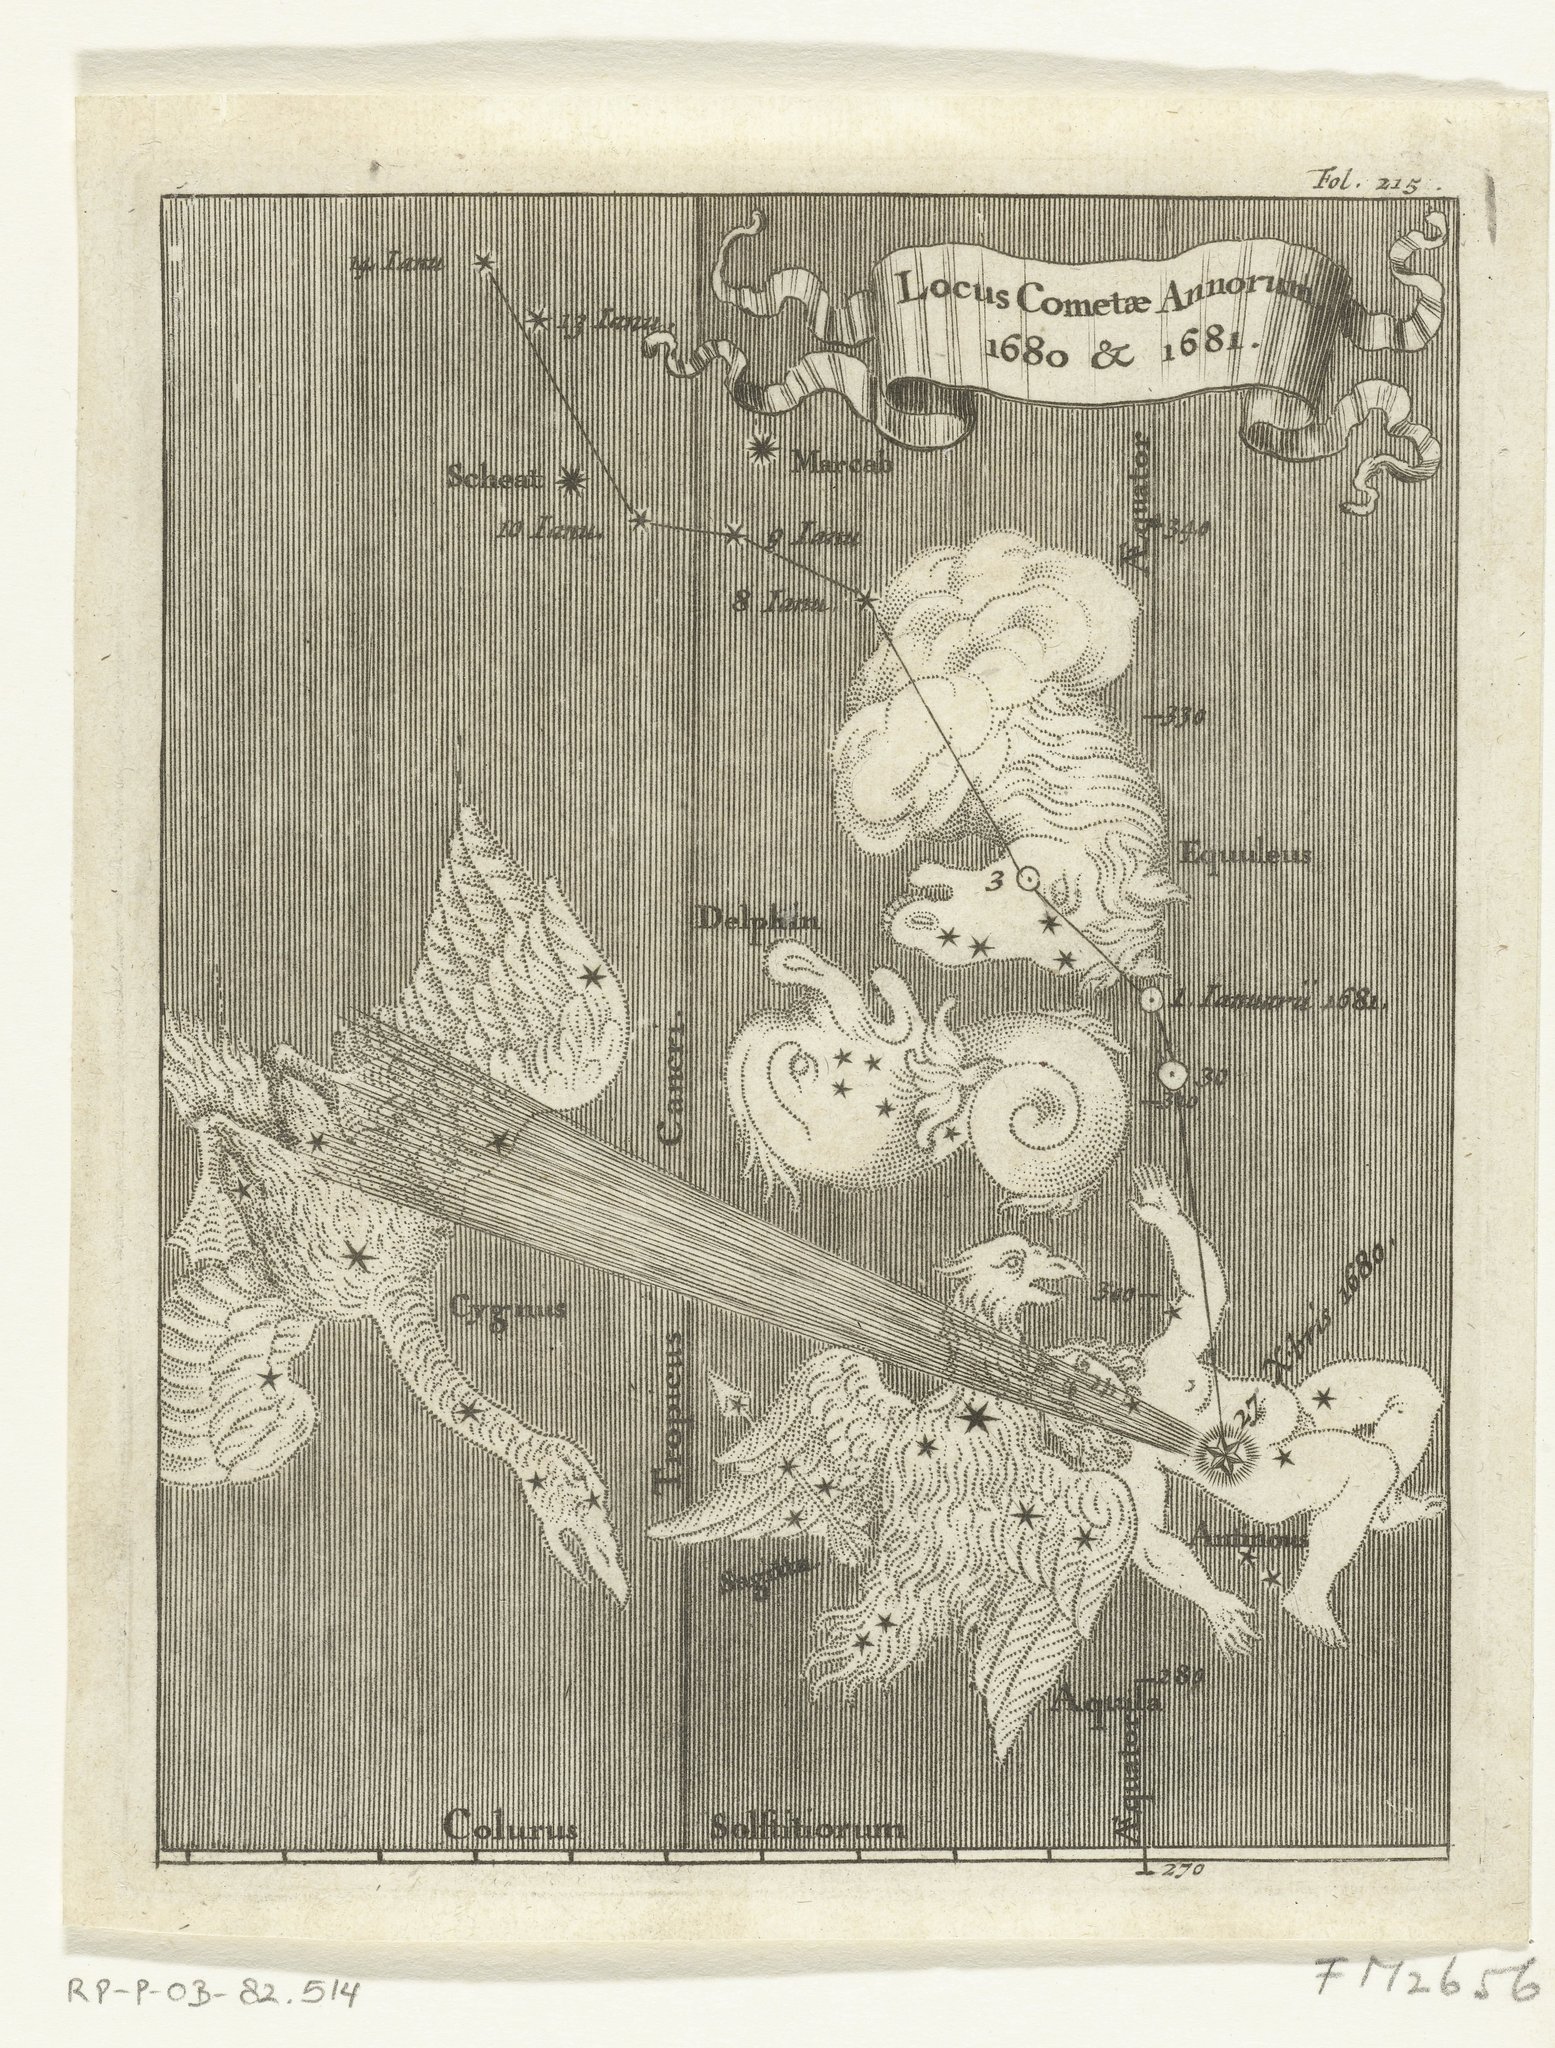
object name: print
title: De komeet van 1680-1681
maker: Anonymous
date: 1680-1681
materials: paper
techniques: engraving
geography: germany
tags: comet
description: De komeet zichtbaar in de winter van 1680-1681. Astronomische voorstelling van de plaats van de komeet tussen de tekens van de Dierenriem. Gemerkt rechtsboven: Fol. 215.